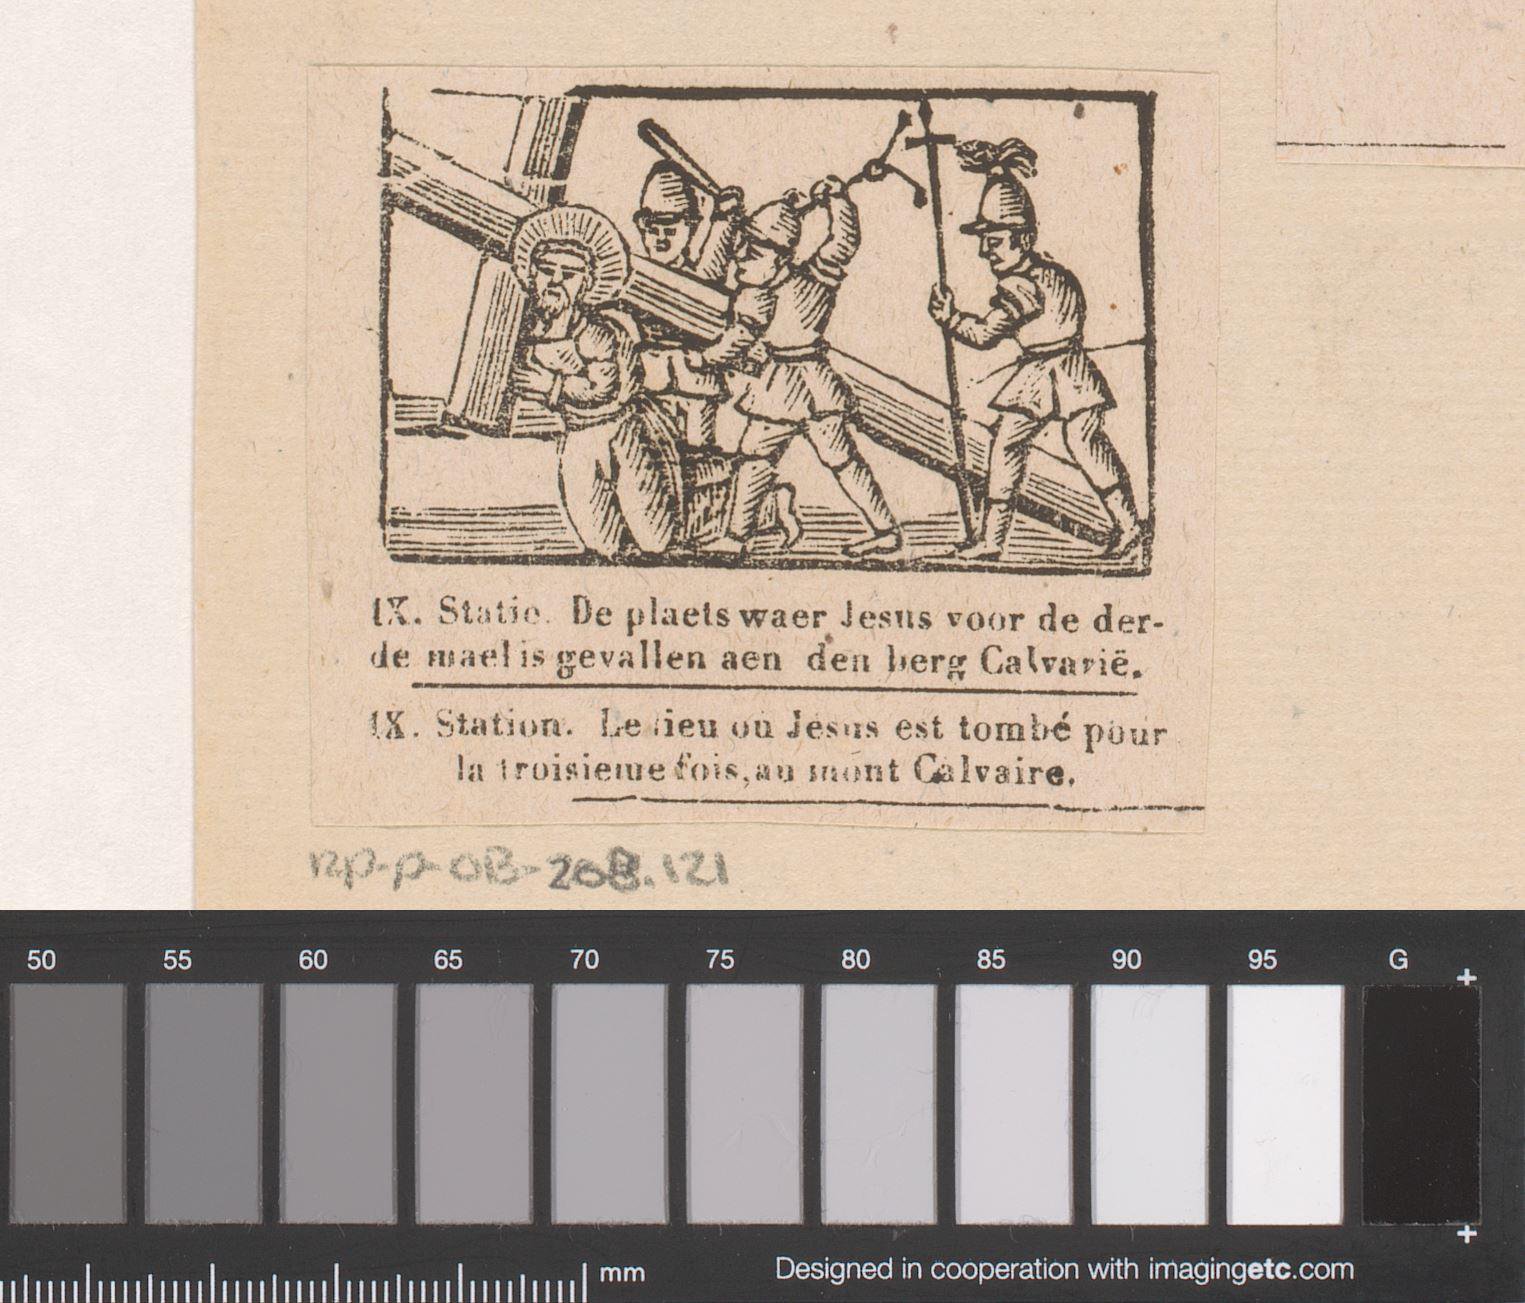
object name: print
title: Kruiswegstatie 9: Christus bezwijkt voor derde keer tijdens de kruisdraging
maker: Anonymous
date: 1600-1699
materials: paper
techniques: letterpress printing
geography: netherlands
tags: the 14 franciscan stations of the cross (9), third fall ~ christ carrying the cross